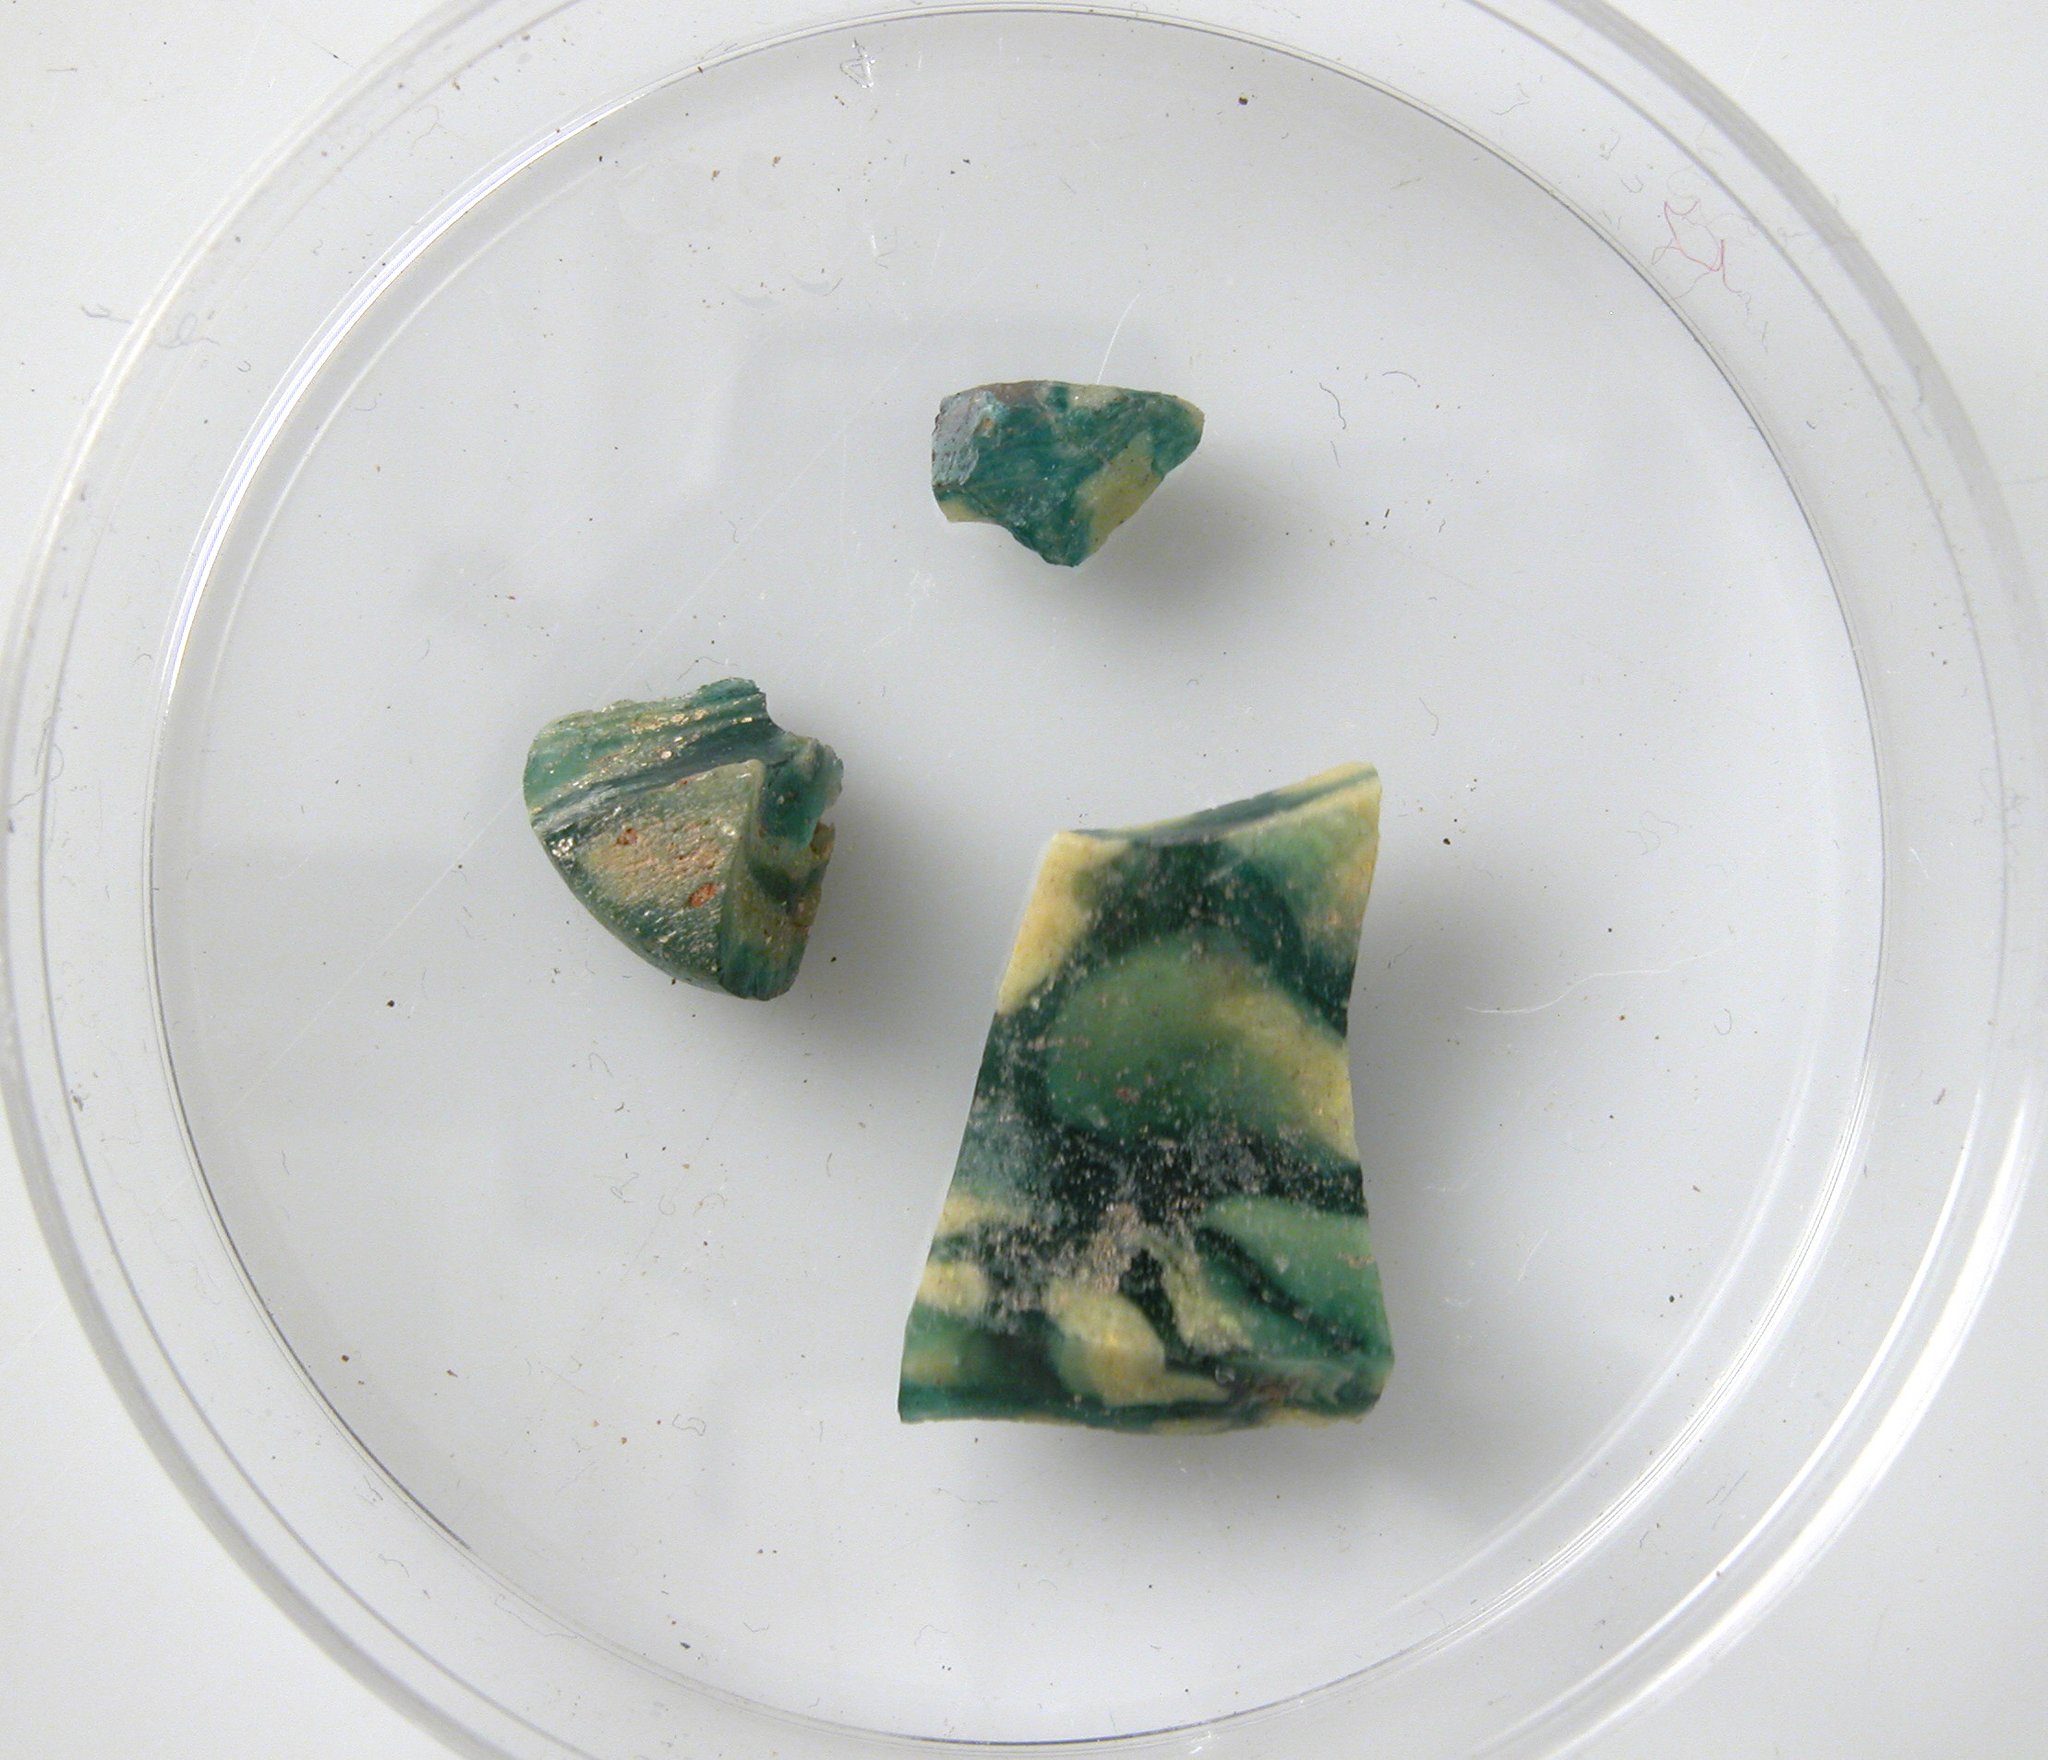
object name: fragment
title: Glass Fragments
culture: coptic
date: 301-700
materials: glass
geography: egypt